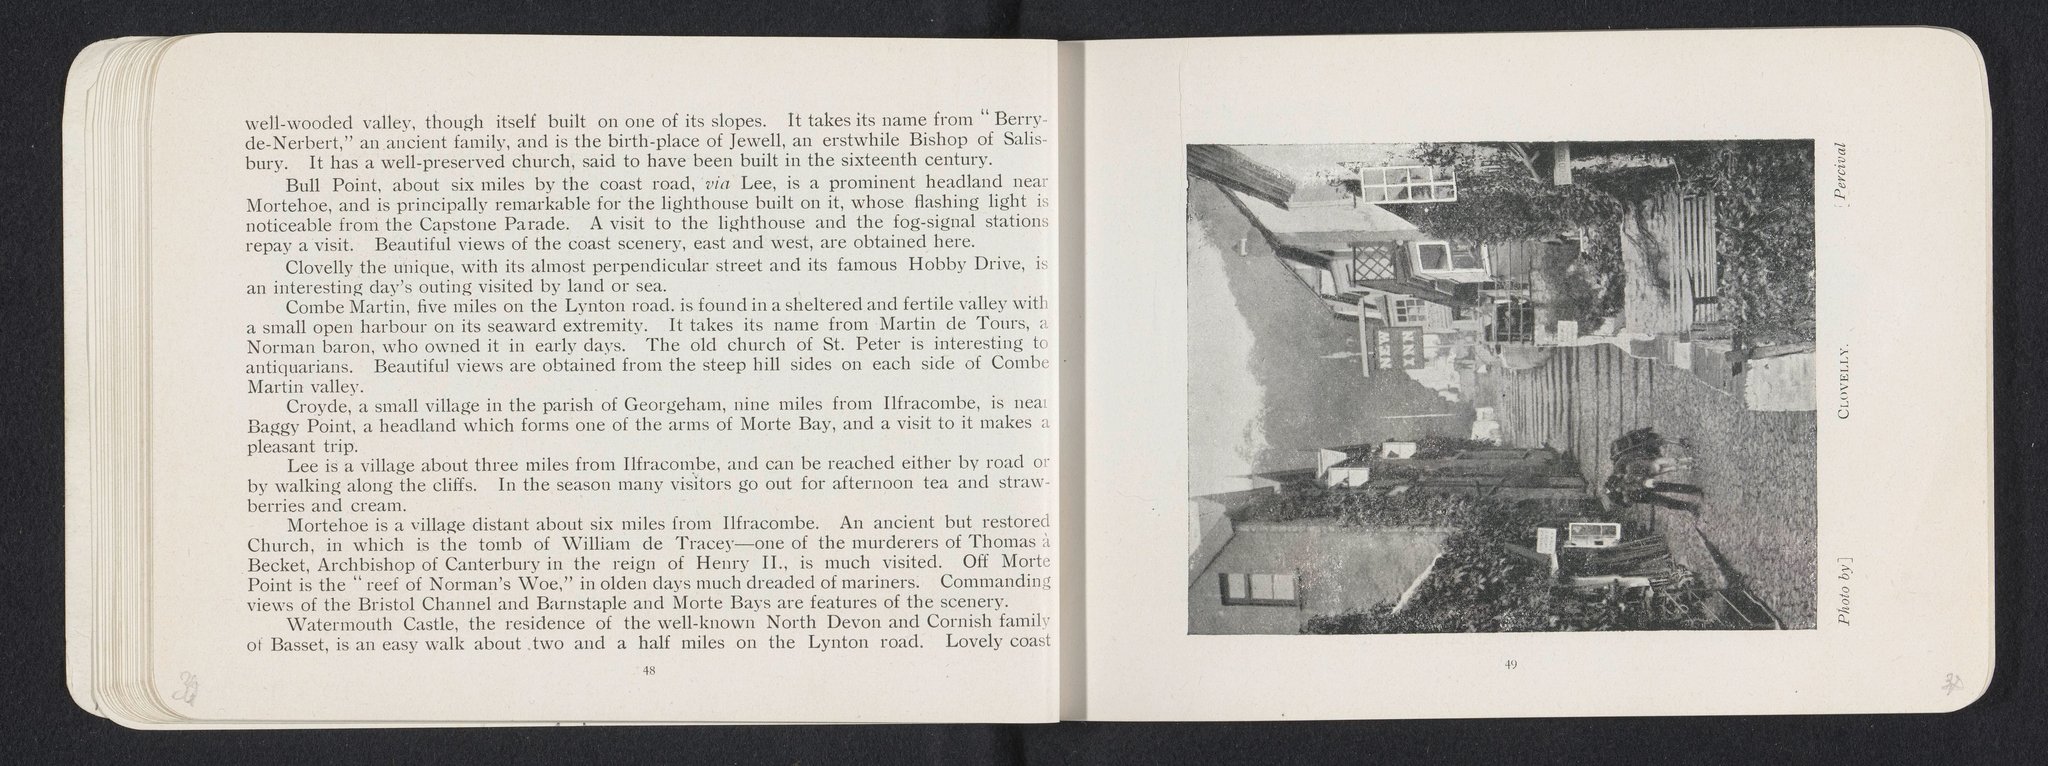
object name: photomechanical print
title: Clovelly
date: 1900-1920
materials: paper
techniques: autotype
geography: clovelly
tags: street